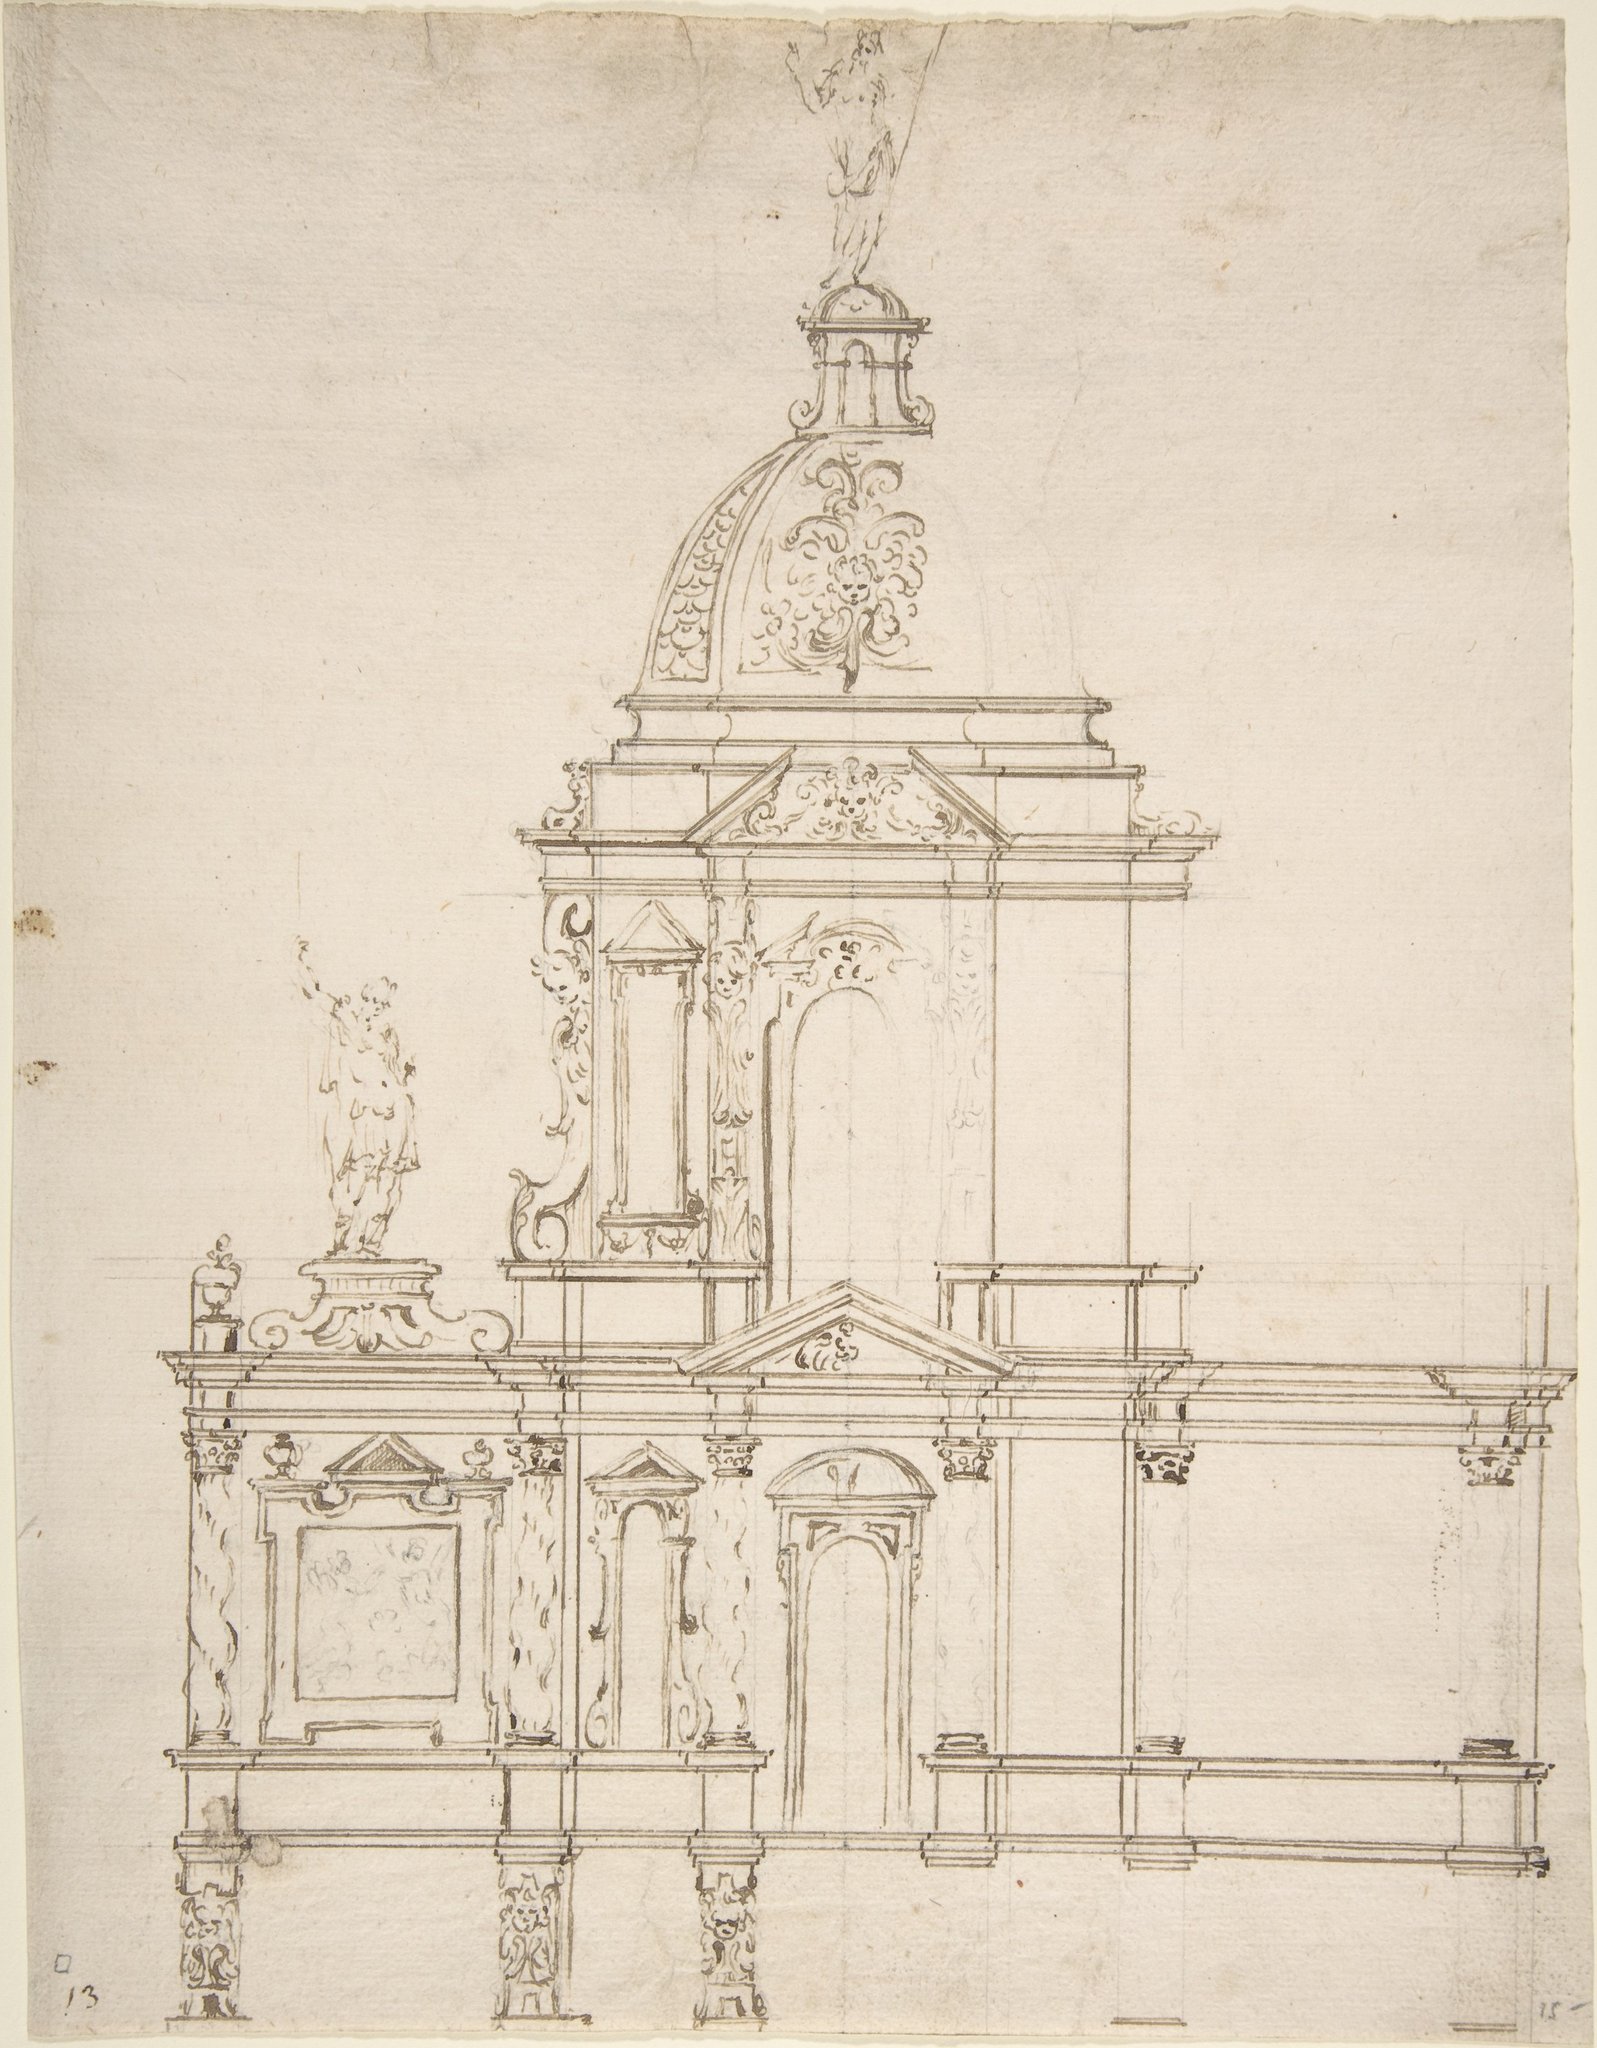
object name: drawing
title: Design for Altar Tabernacle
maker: anonymous, french, 17th century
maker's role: artist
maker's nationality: french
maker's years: 1600-1700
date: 1601-1700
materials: chalk, ink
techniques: pen, drawing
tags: tabernacles